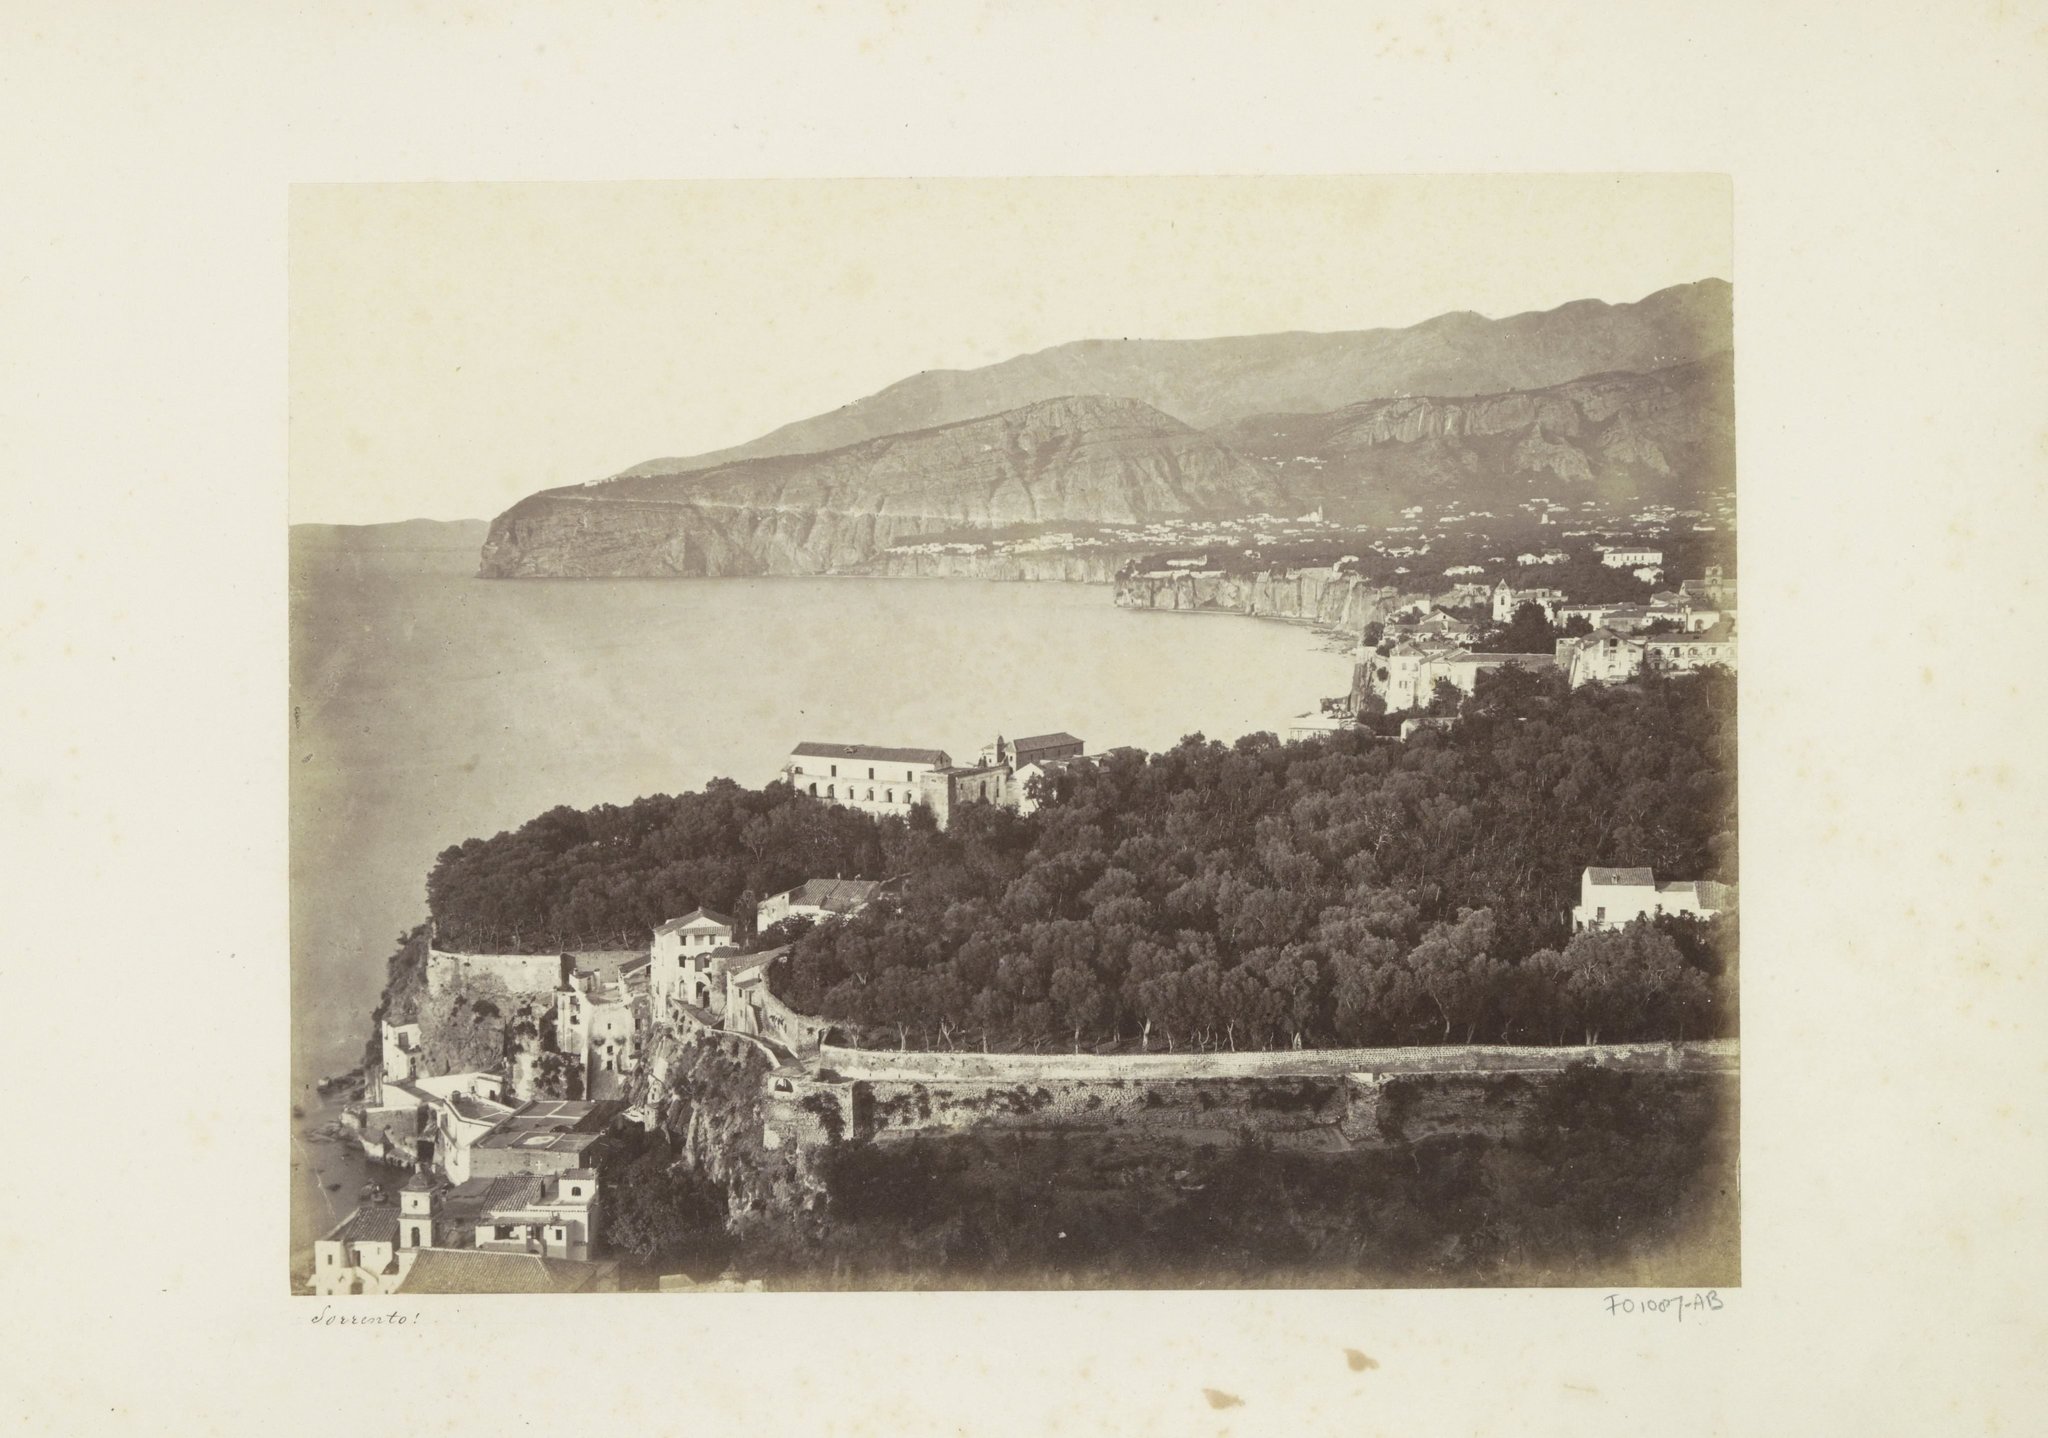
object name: photograph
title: Sorrento!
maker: Anonymous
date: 1865-1875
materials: paper, photographic support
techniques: albumen print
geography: sorrento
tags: prospect of village, silhouette of village, gulf, bay (+ landscape with figures, staffage), sorrento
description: Onderdeel van Reisalbum met foto's van bezienswaardigheden in Napels en omgeving.